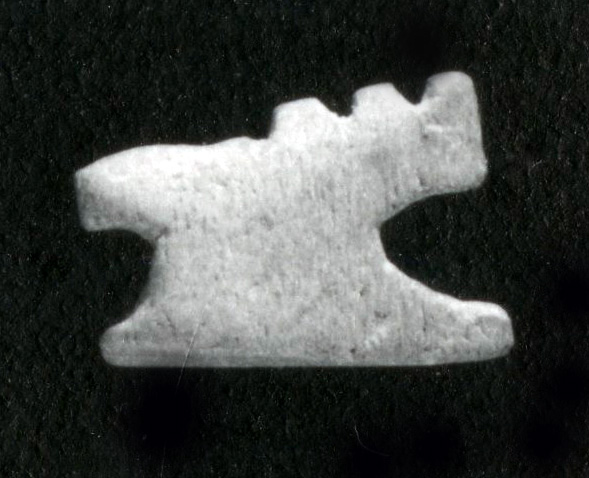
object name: amulet, lion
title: Lion amulet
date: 2110-2030 BCE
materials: ivory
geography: egypt